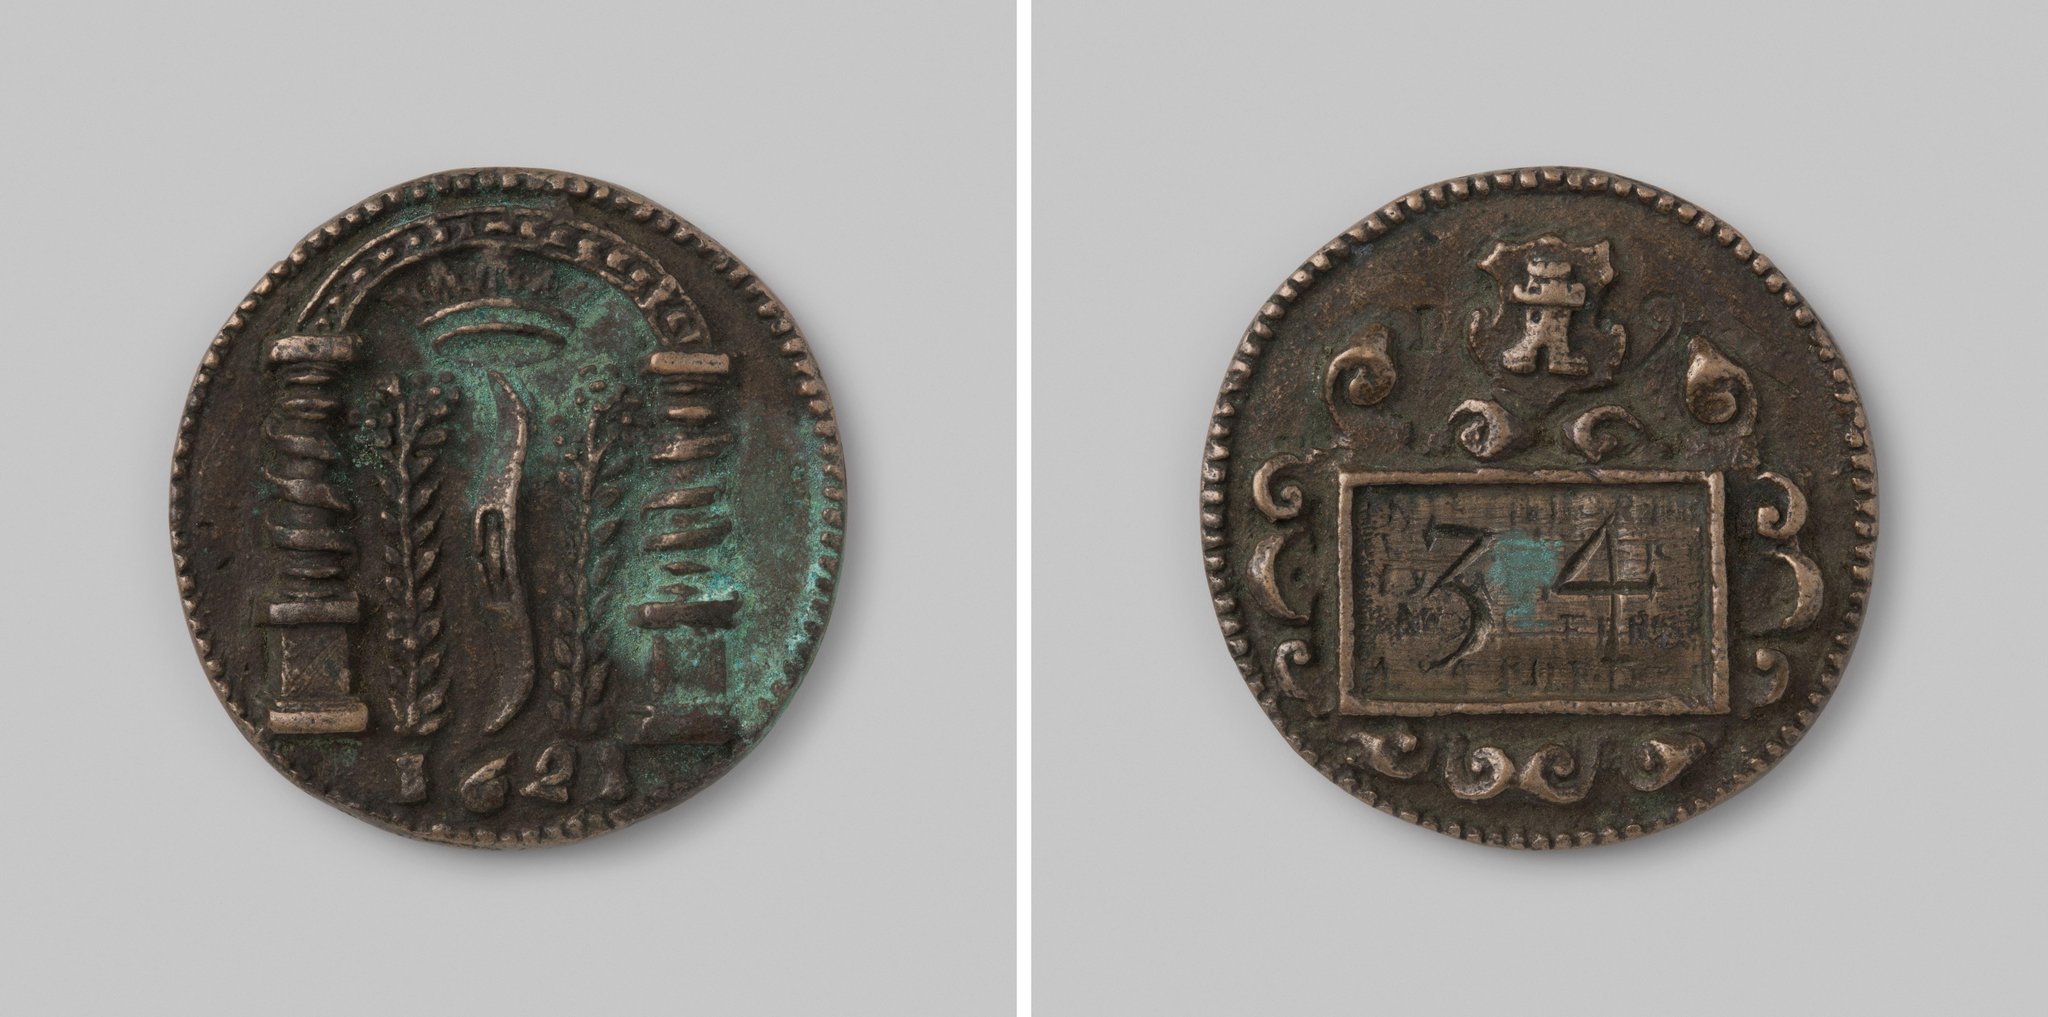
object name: medal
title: Presentiepenning van het Weversgilde te Middelburg, 1621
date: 1621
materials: brass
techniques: casting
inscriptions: inscription, inscription: ‘19’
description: Gegoten messing penning, op de voorzijde een gekroonde weversspoel tussen twee vlasplanten onder een ereboog op twee zuilen, onderaan het jaartal 1621, op de keerzijde een klein wapenschild Middelburg waarnaast gegraveerd 19, boven een versierde rechthoekige ruimte waarin oorspronkelijke tekst is weggeslepen en vervangen door de inscriptie 34